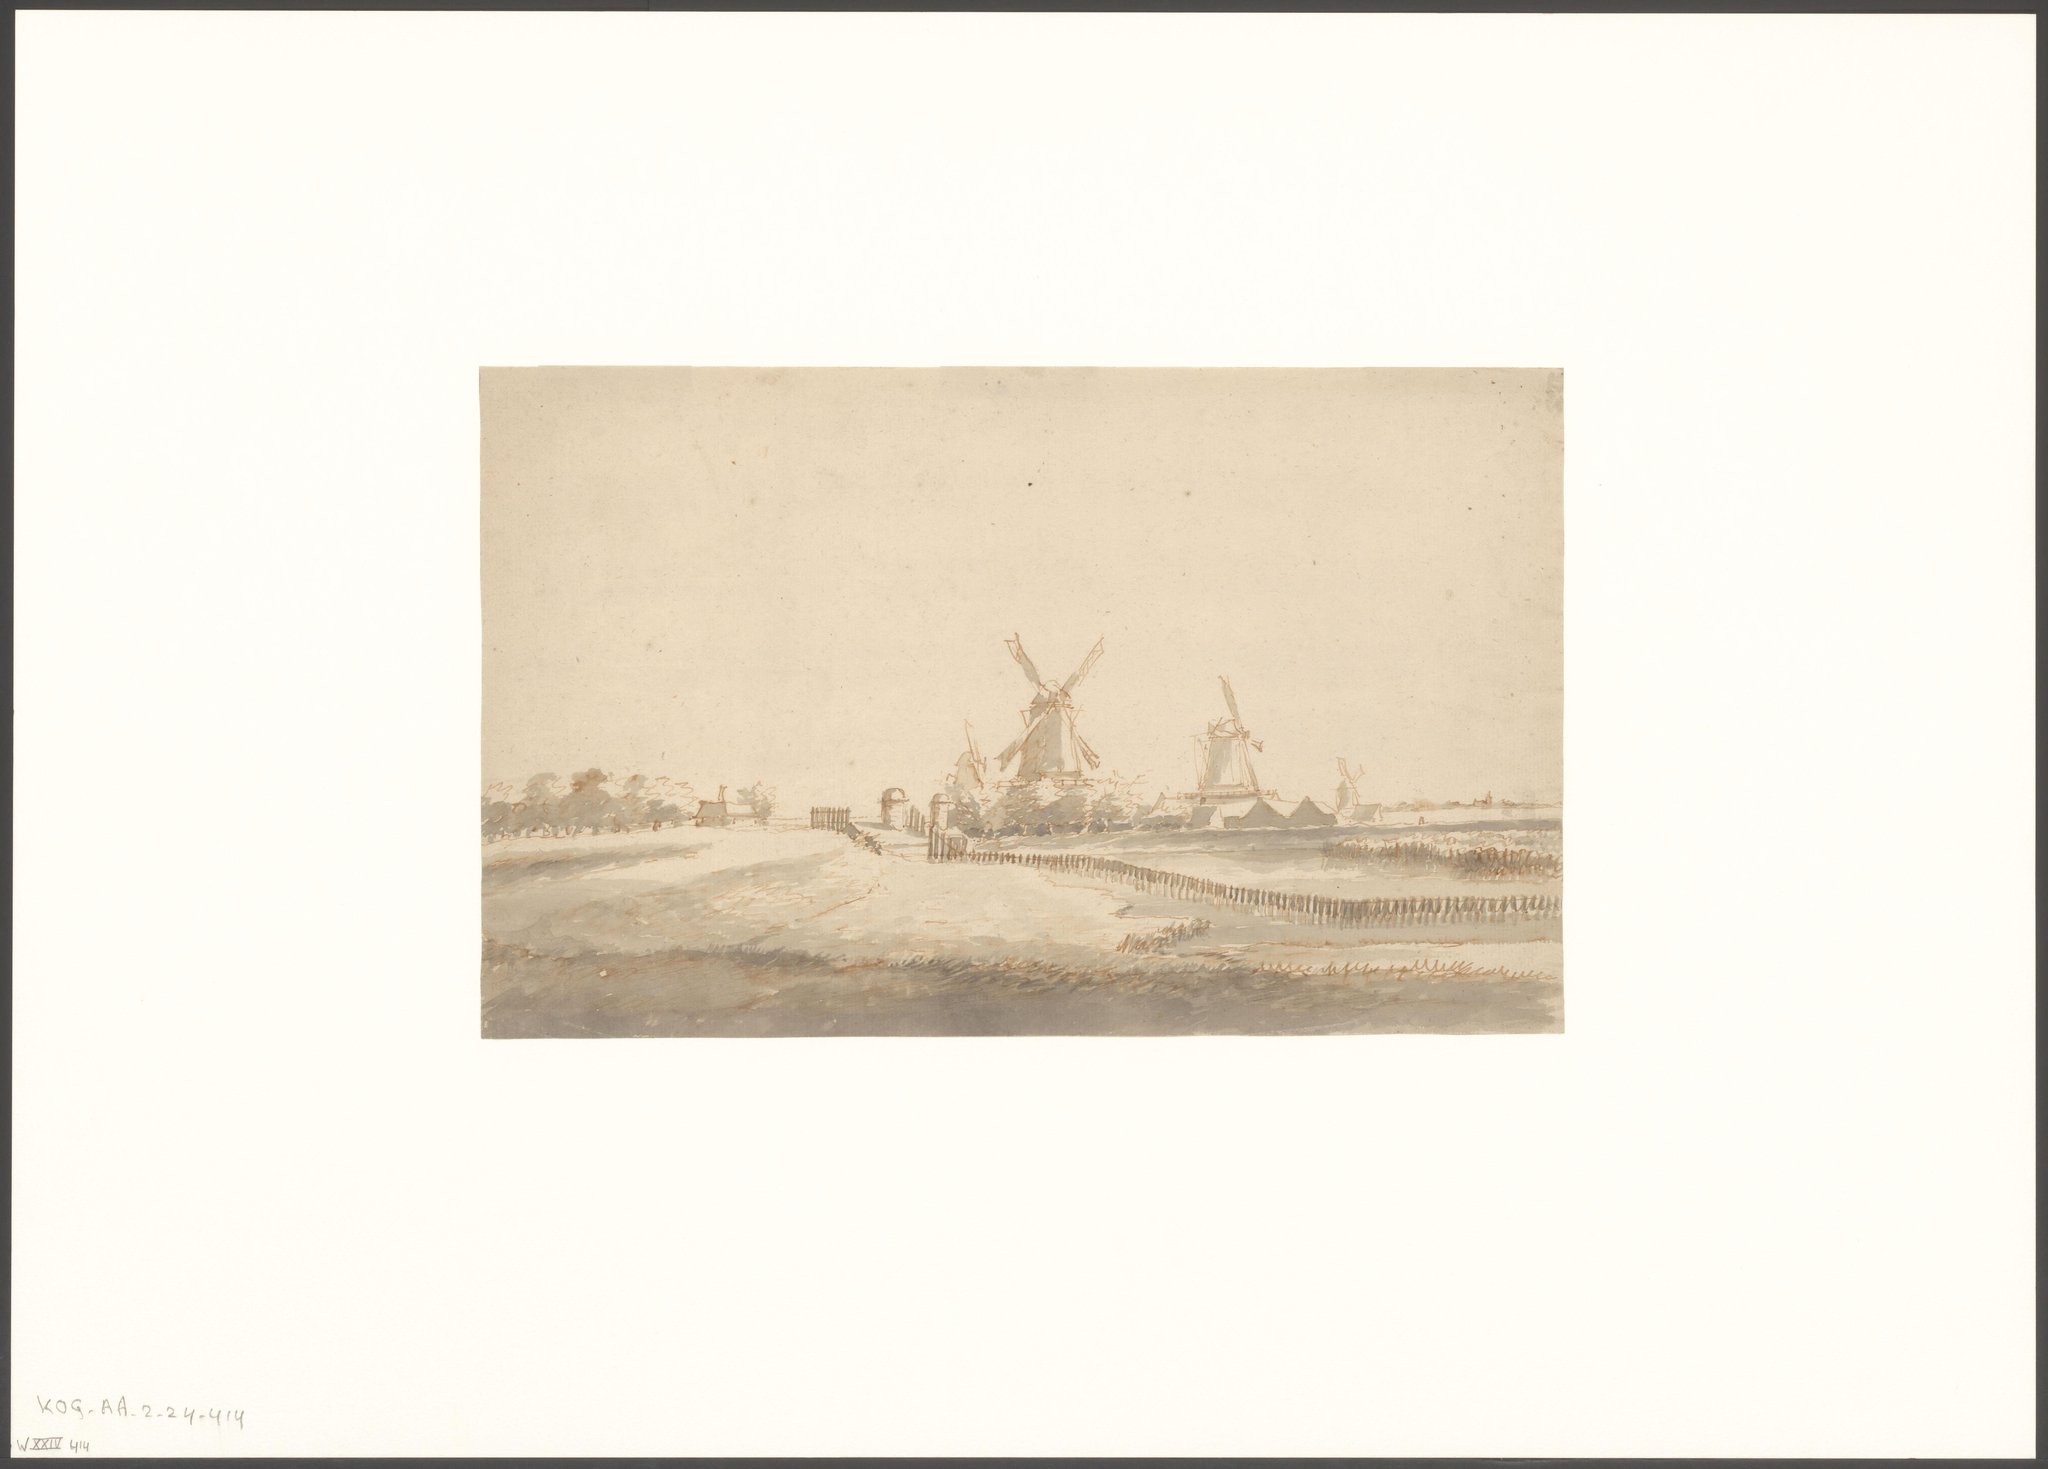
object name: drawing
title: Gezicht op bolwerk Westerbeer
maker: Anonymous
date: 1600-1699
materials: ink, paper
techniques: brush, pen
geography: amsterdam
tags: city-view in general; 'veduta', windmill in landscape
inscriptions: collector's mark: Lugt 800a, inscription: ‘439b / Hartkamp 114’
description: Tekening binnen de Atlas Van Eck ingedeeld op wijknummer 24.